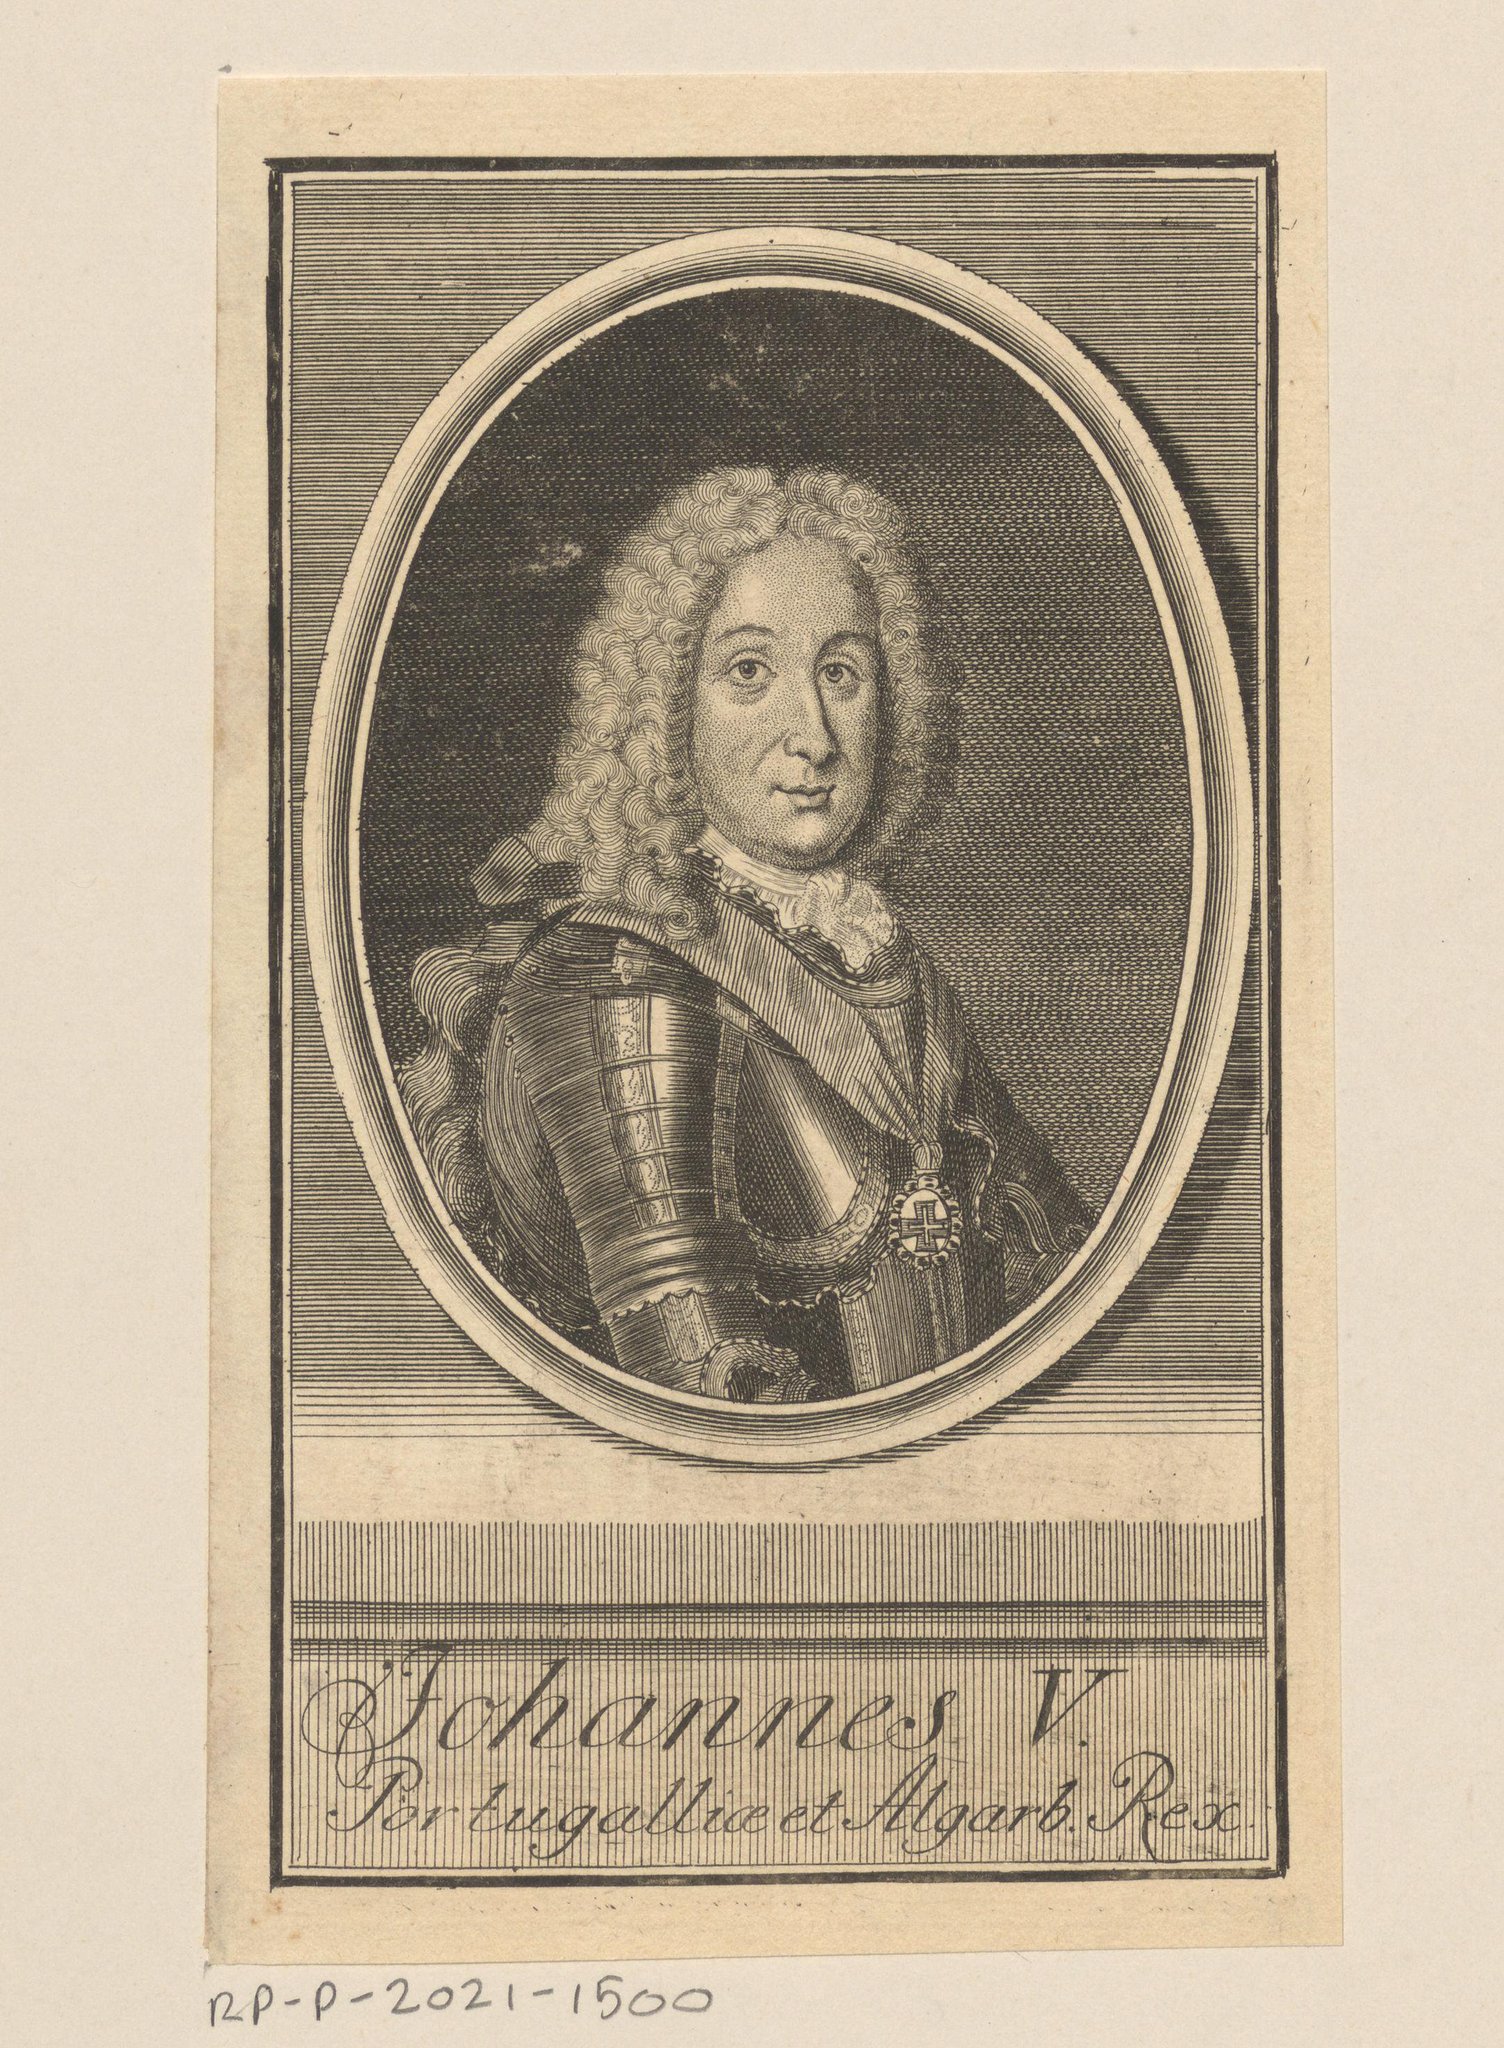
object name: print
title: Portret van Johan V, koning van Portugal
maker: Anonymous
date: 1706-1799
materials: paper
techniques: engraving, etching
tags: knighthood order, historical persons, king